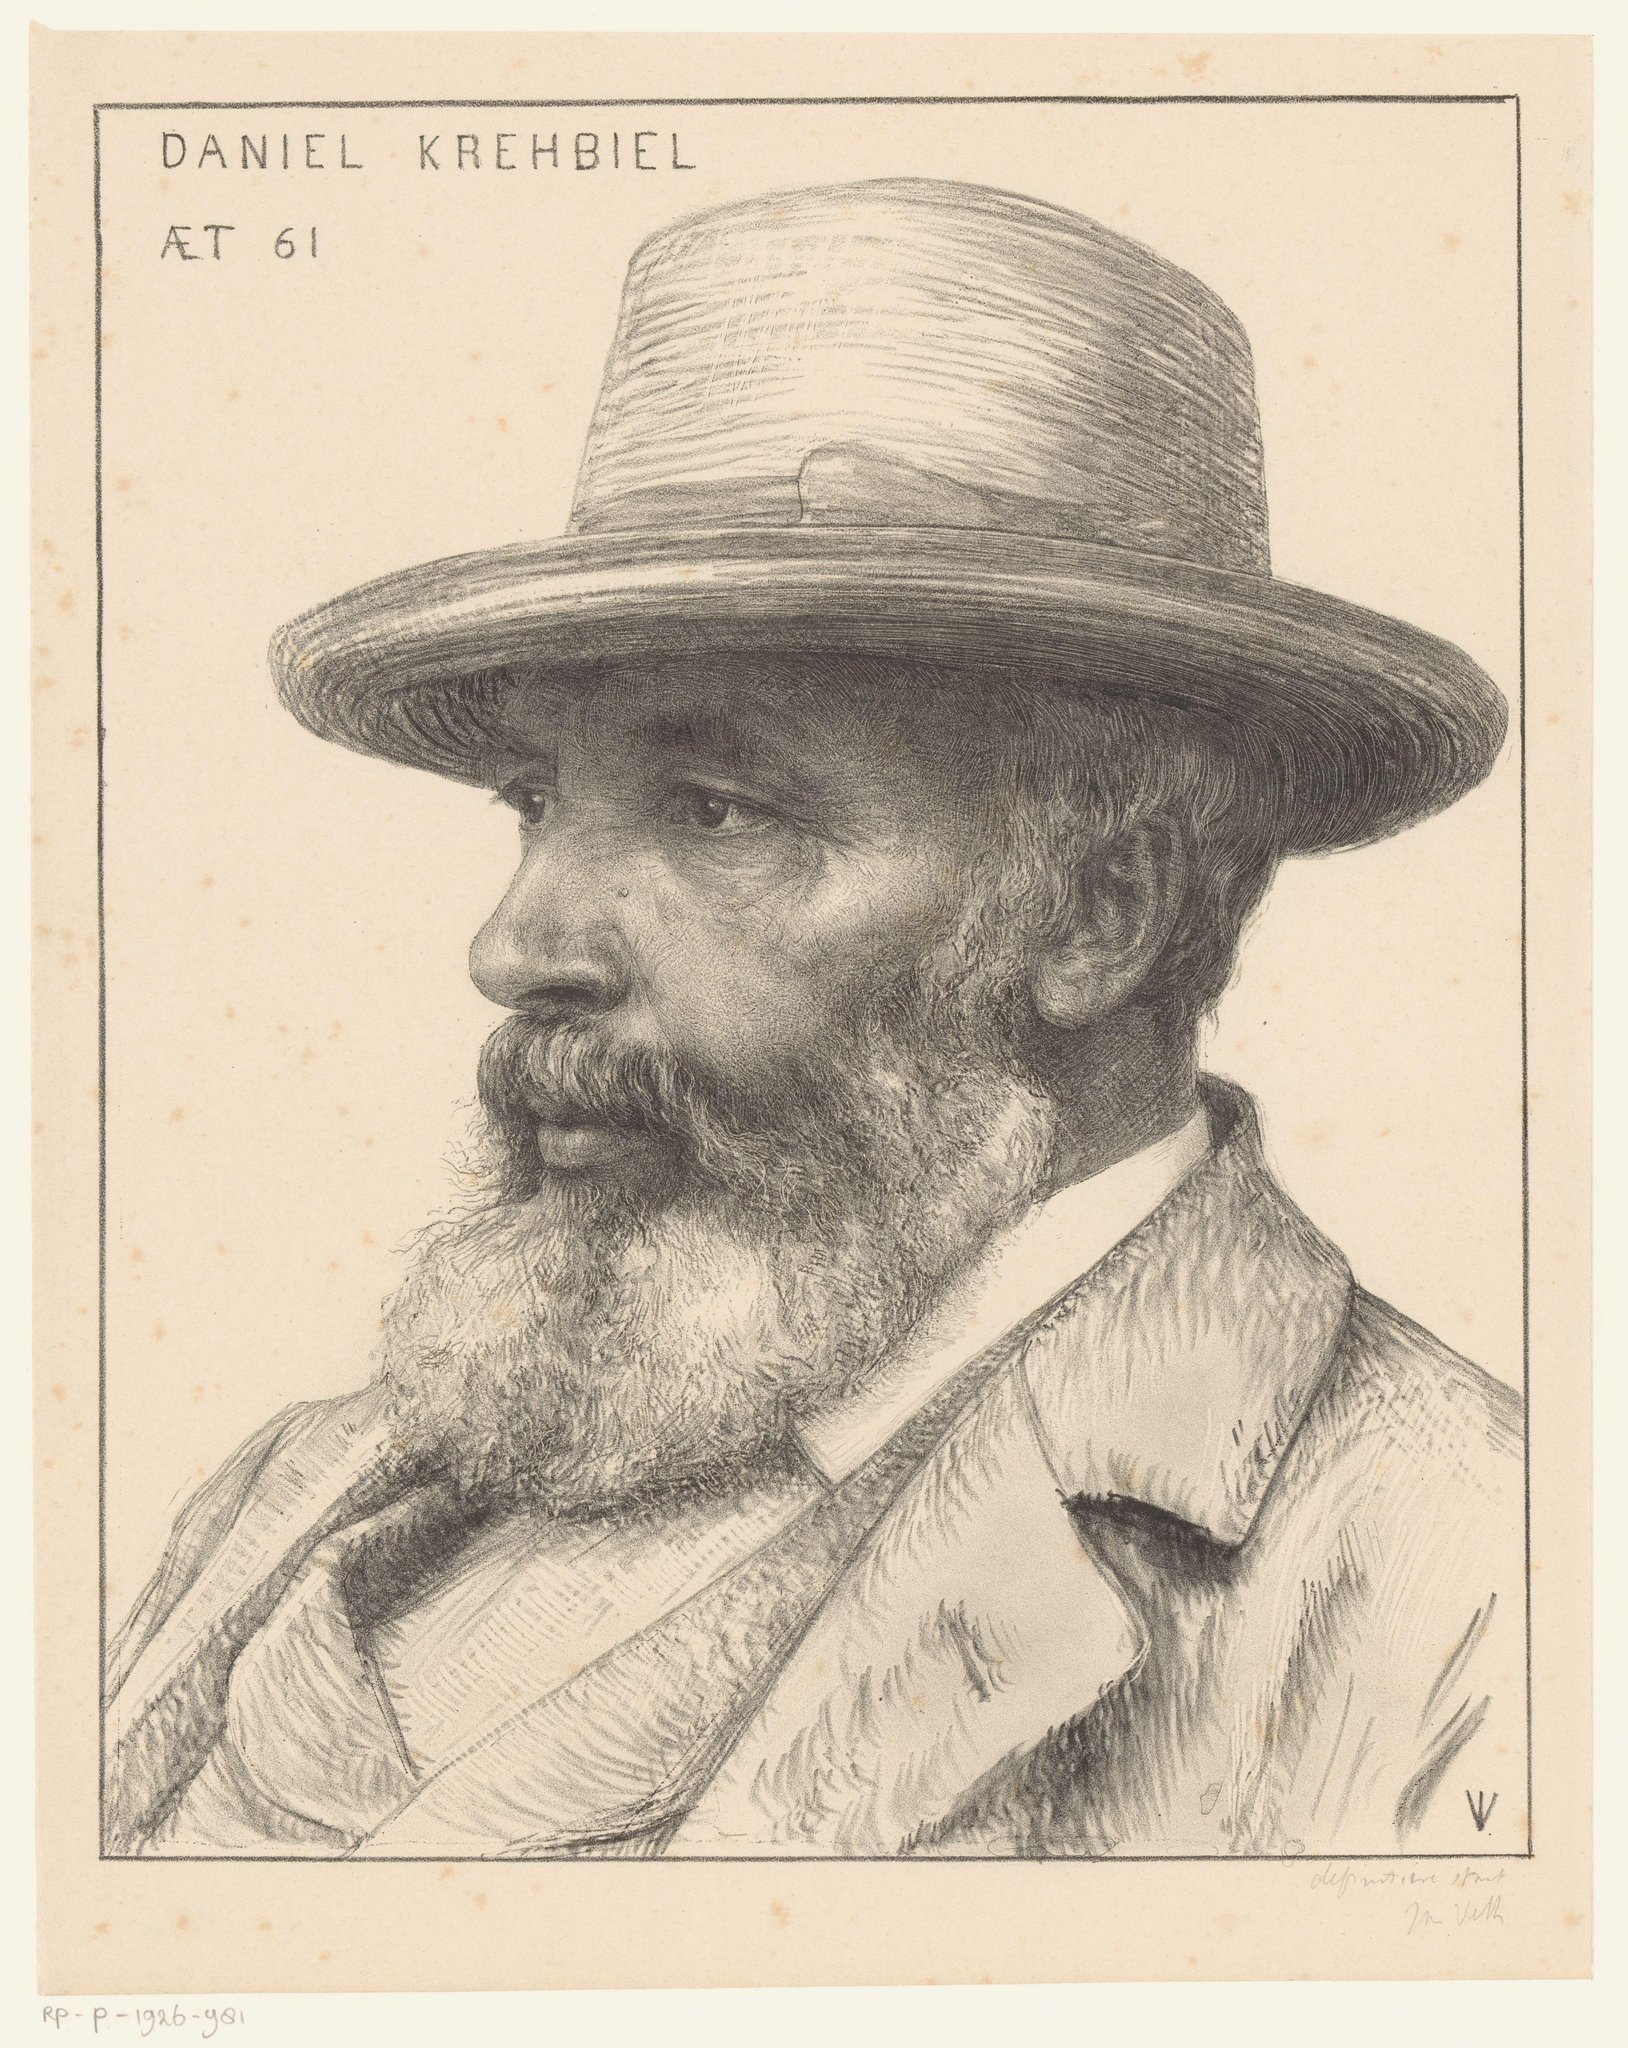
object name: print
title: Portret van Daniel Krehbiel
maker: jan veth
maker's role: designer, draughtsman, painter, print maker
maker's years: 1864-1925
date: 1904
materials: paper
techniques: lithograph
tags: historical persons (+ (full) bust portrait)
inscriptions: inscription: ‘Definitieve staat / Jan Veth’, collector's mark: Lugt 2228